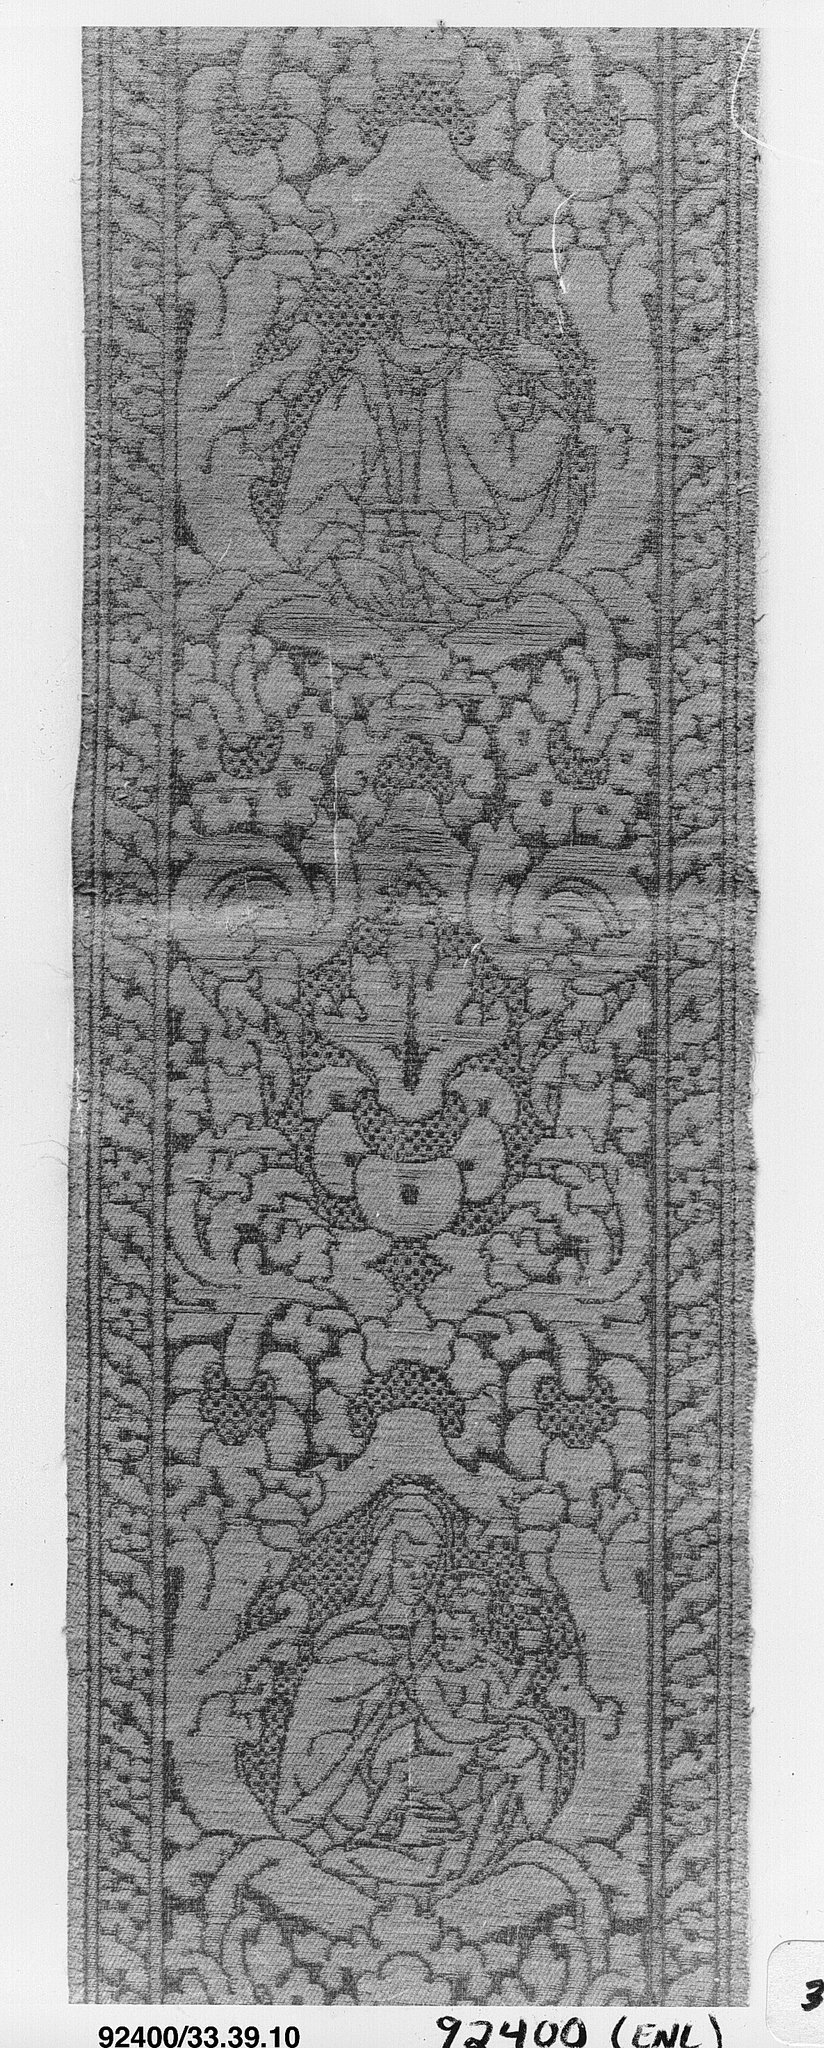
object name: orphrey fragment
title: Orphrey woven with figurative design of Saint Peter and the Virgin and Child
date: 1401-1600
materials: linen, silk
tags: infants,men,women